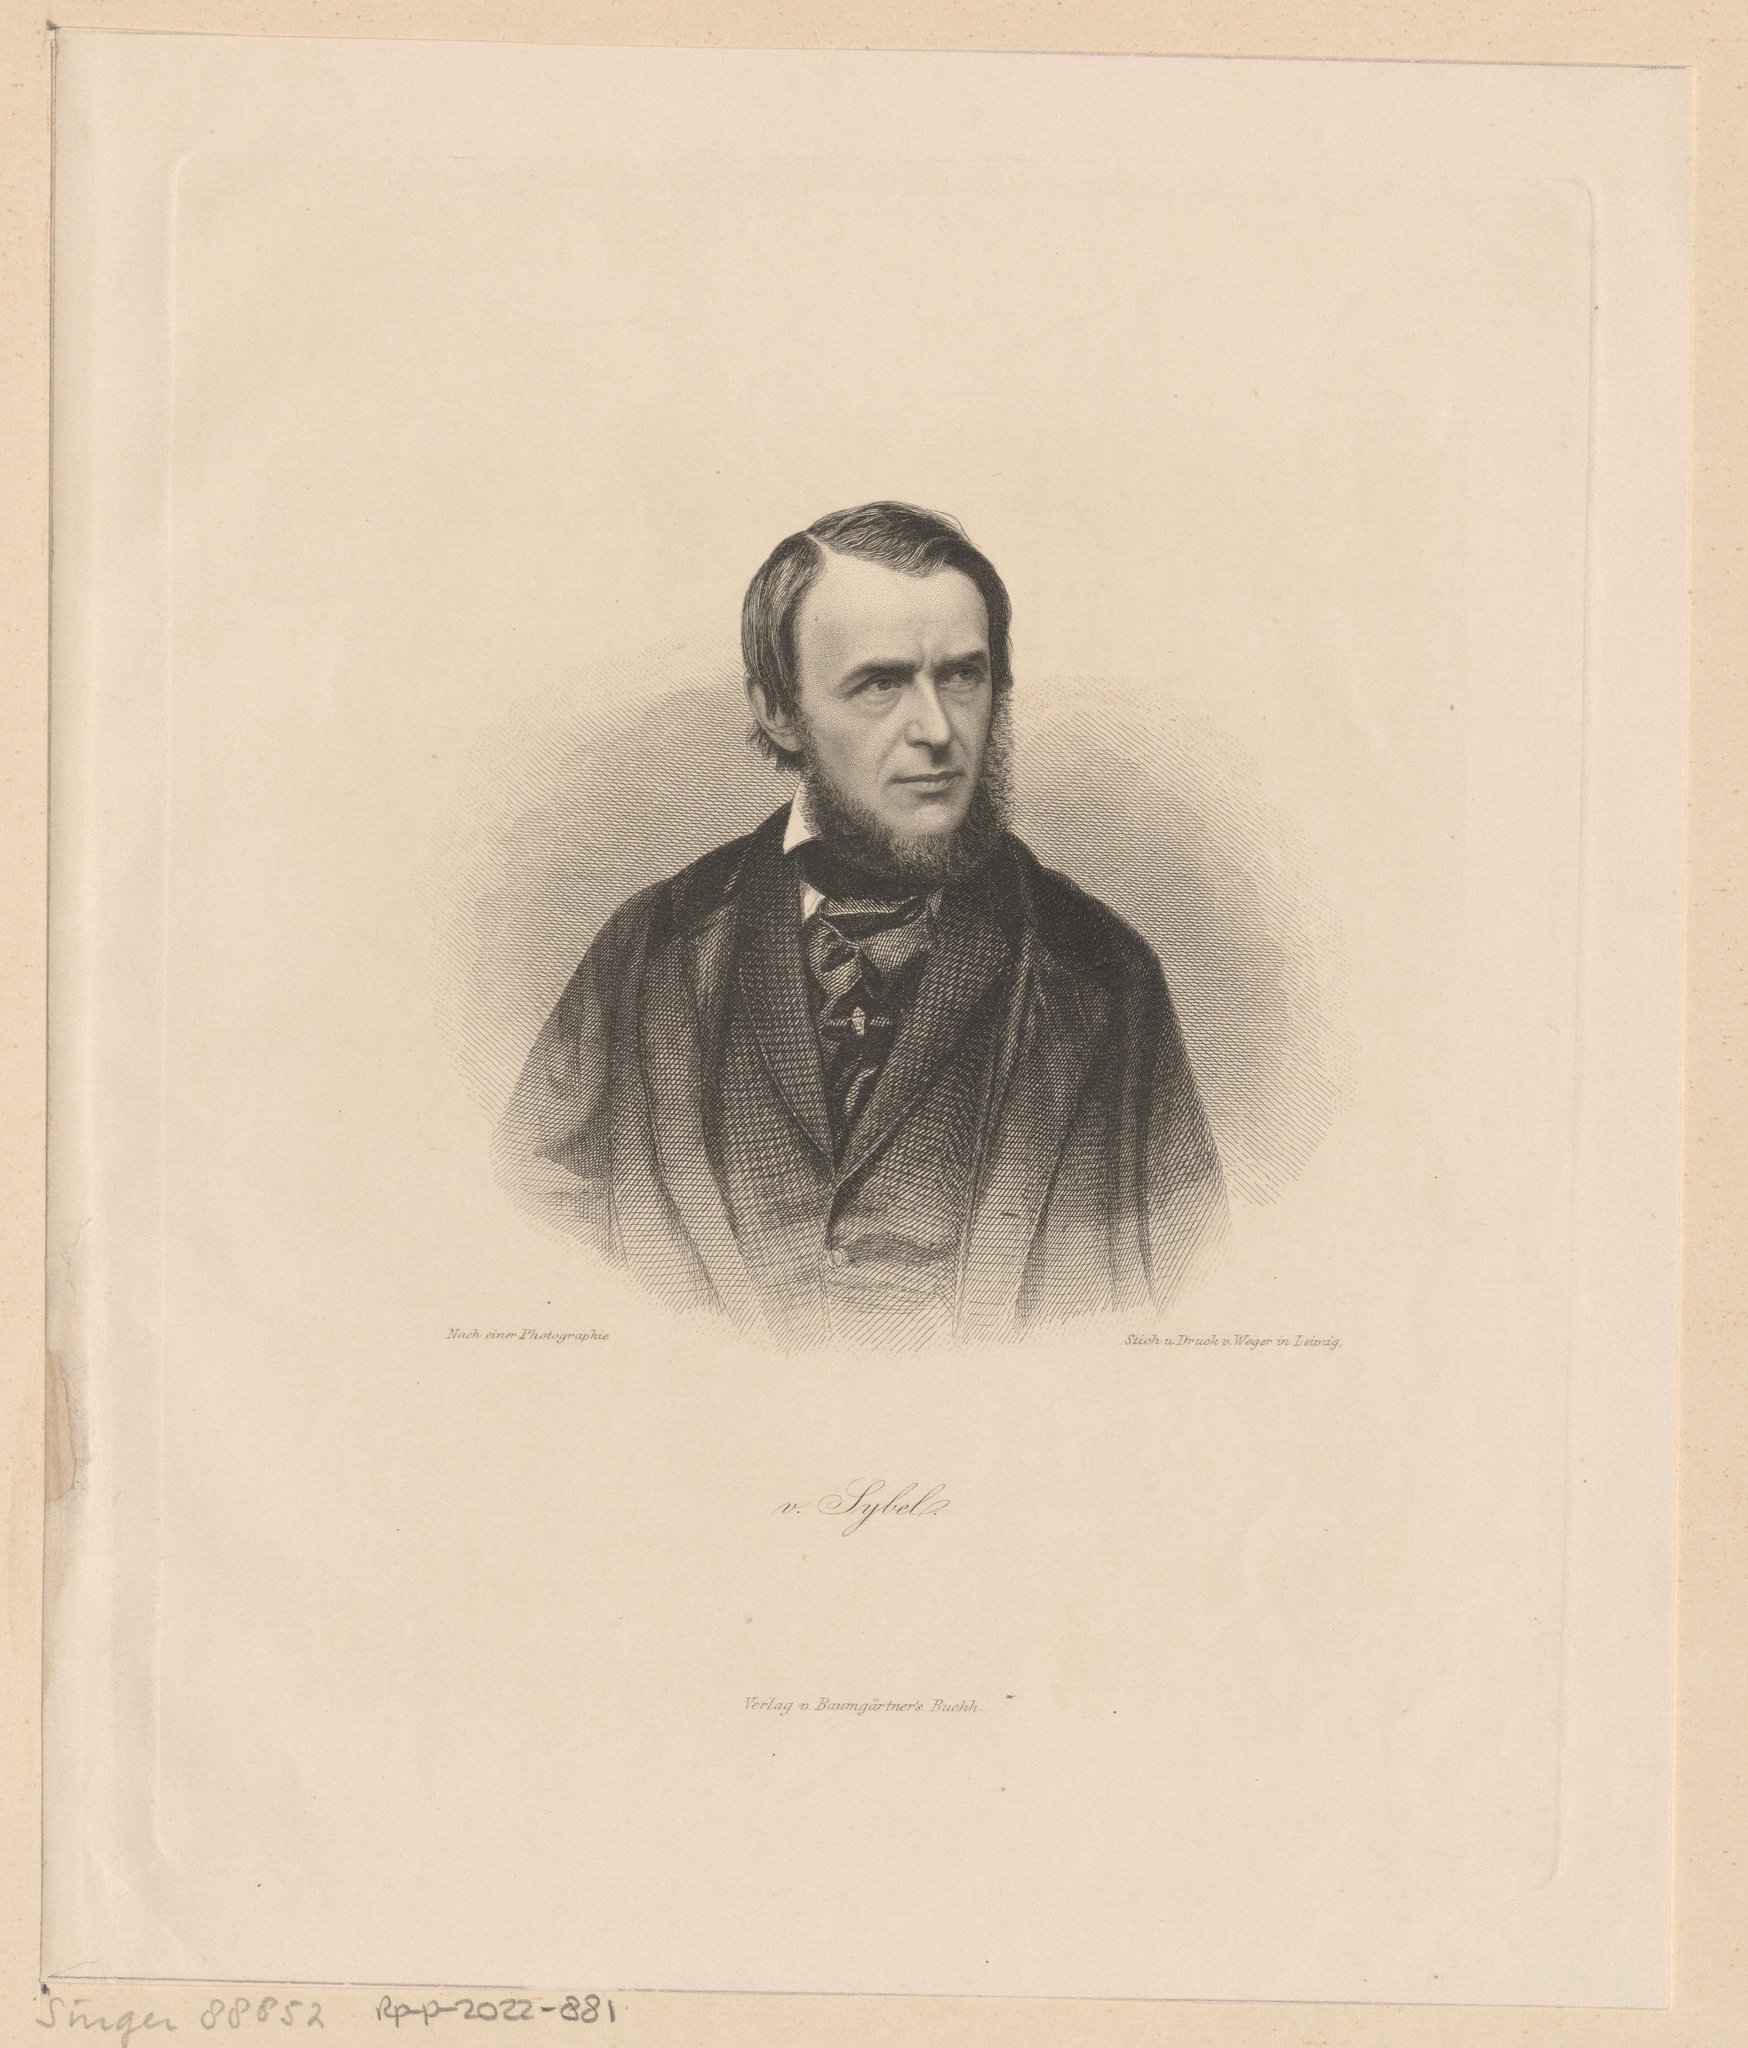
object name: print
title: Portret van Heinrich von Sybel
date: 1847-1892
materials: paper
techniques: engraving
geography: leipzig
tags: politician, historical persons, politician, e.g. party leader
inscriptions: collector's mark: Lugt 2233